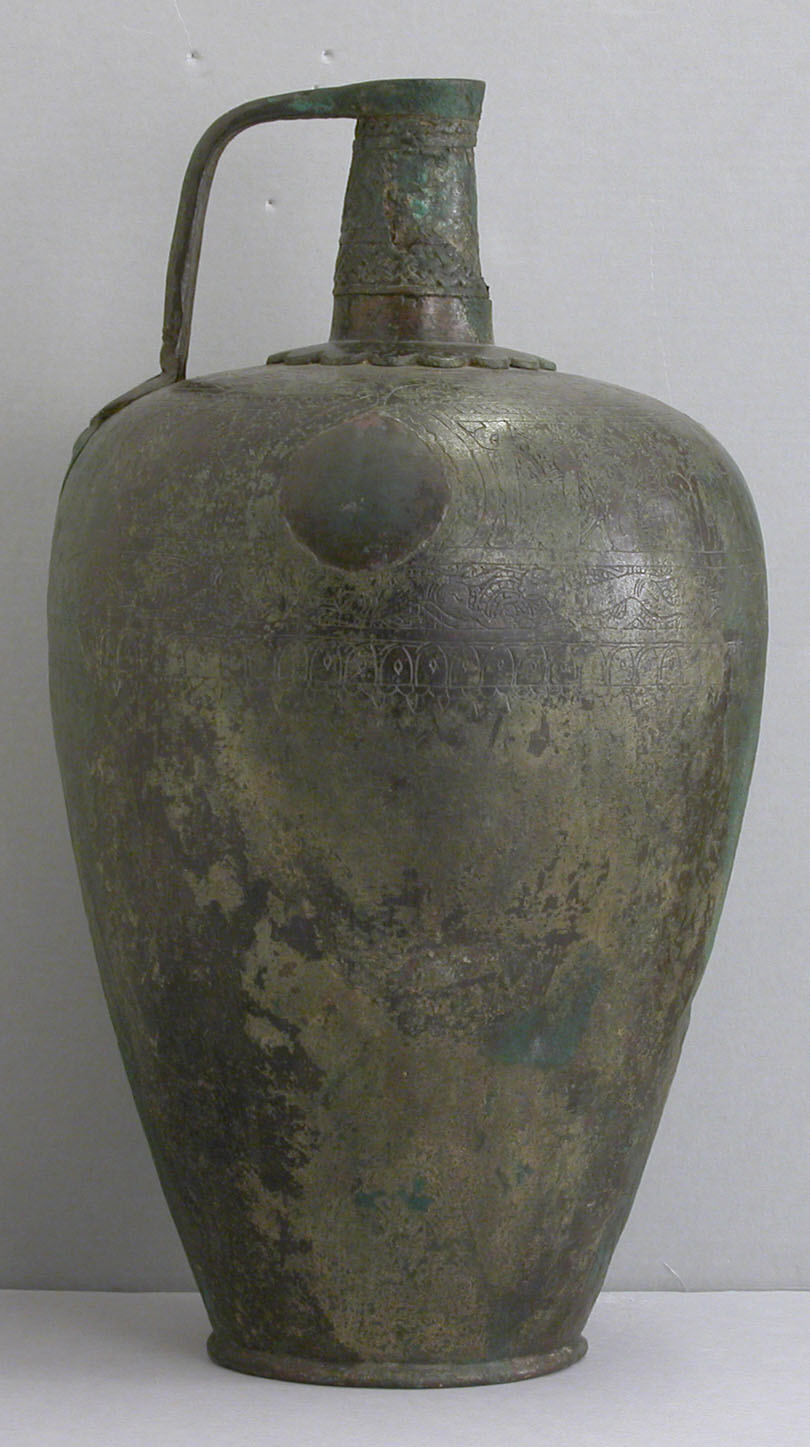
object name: vase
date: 1101-1200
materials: bronze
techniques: engraving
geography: iran